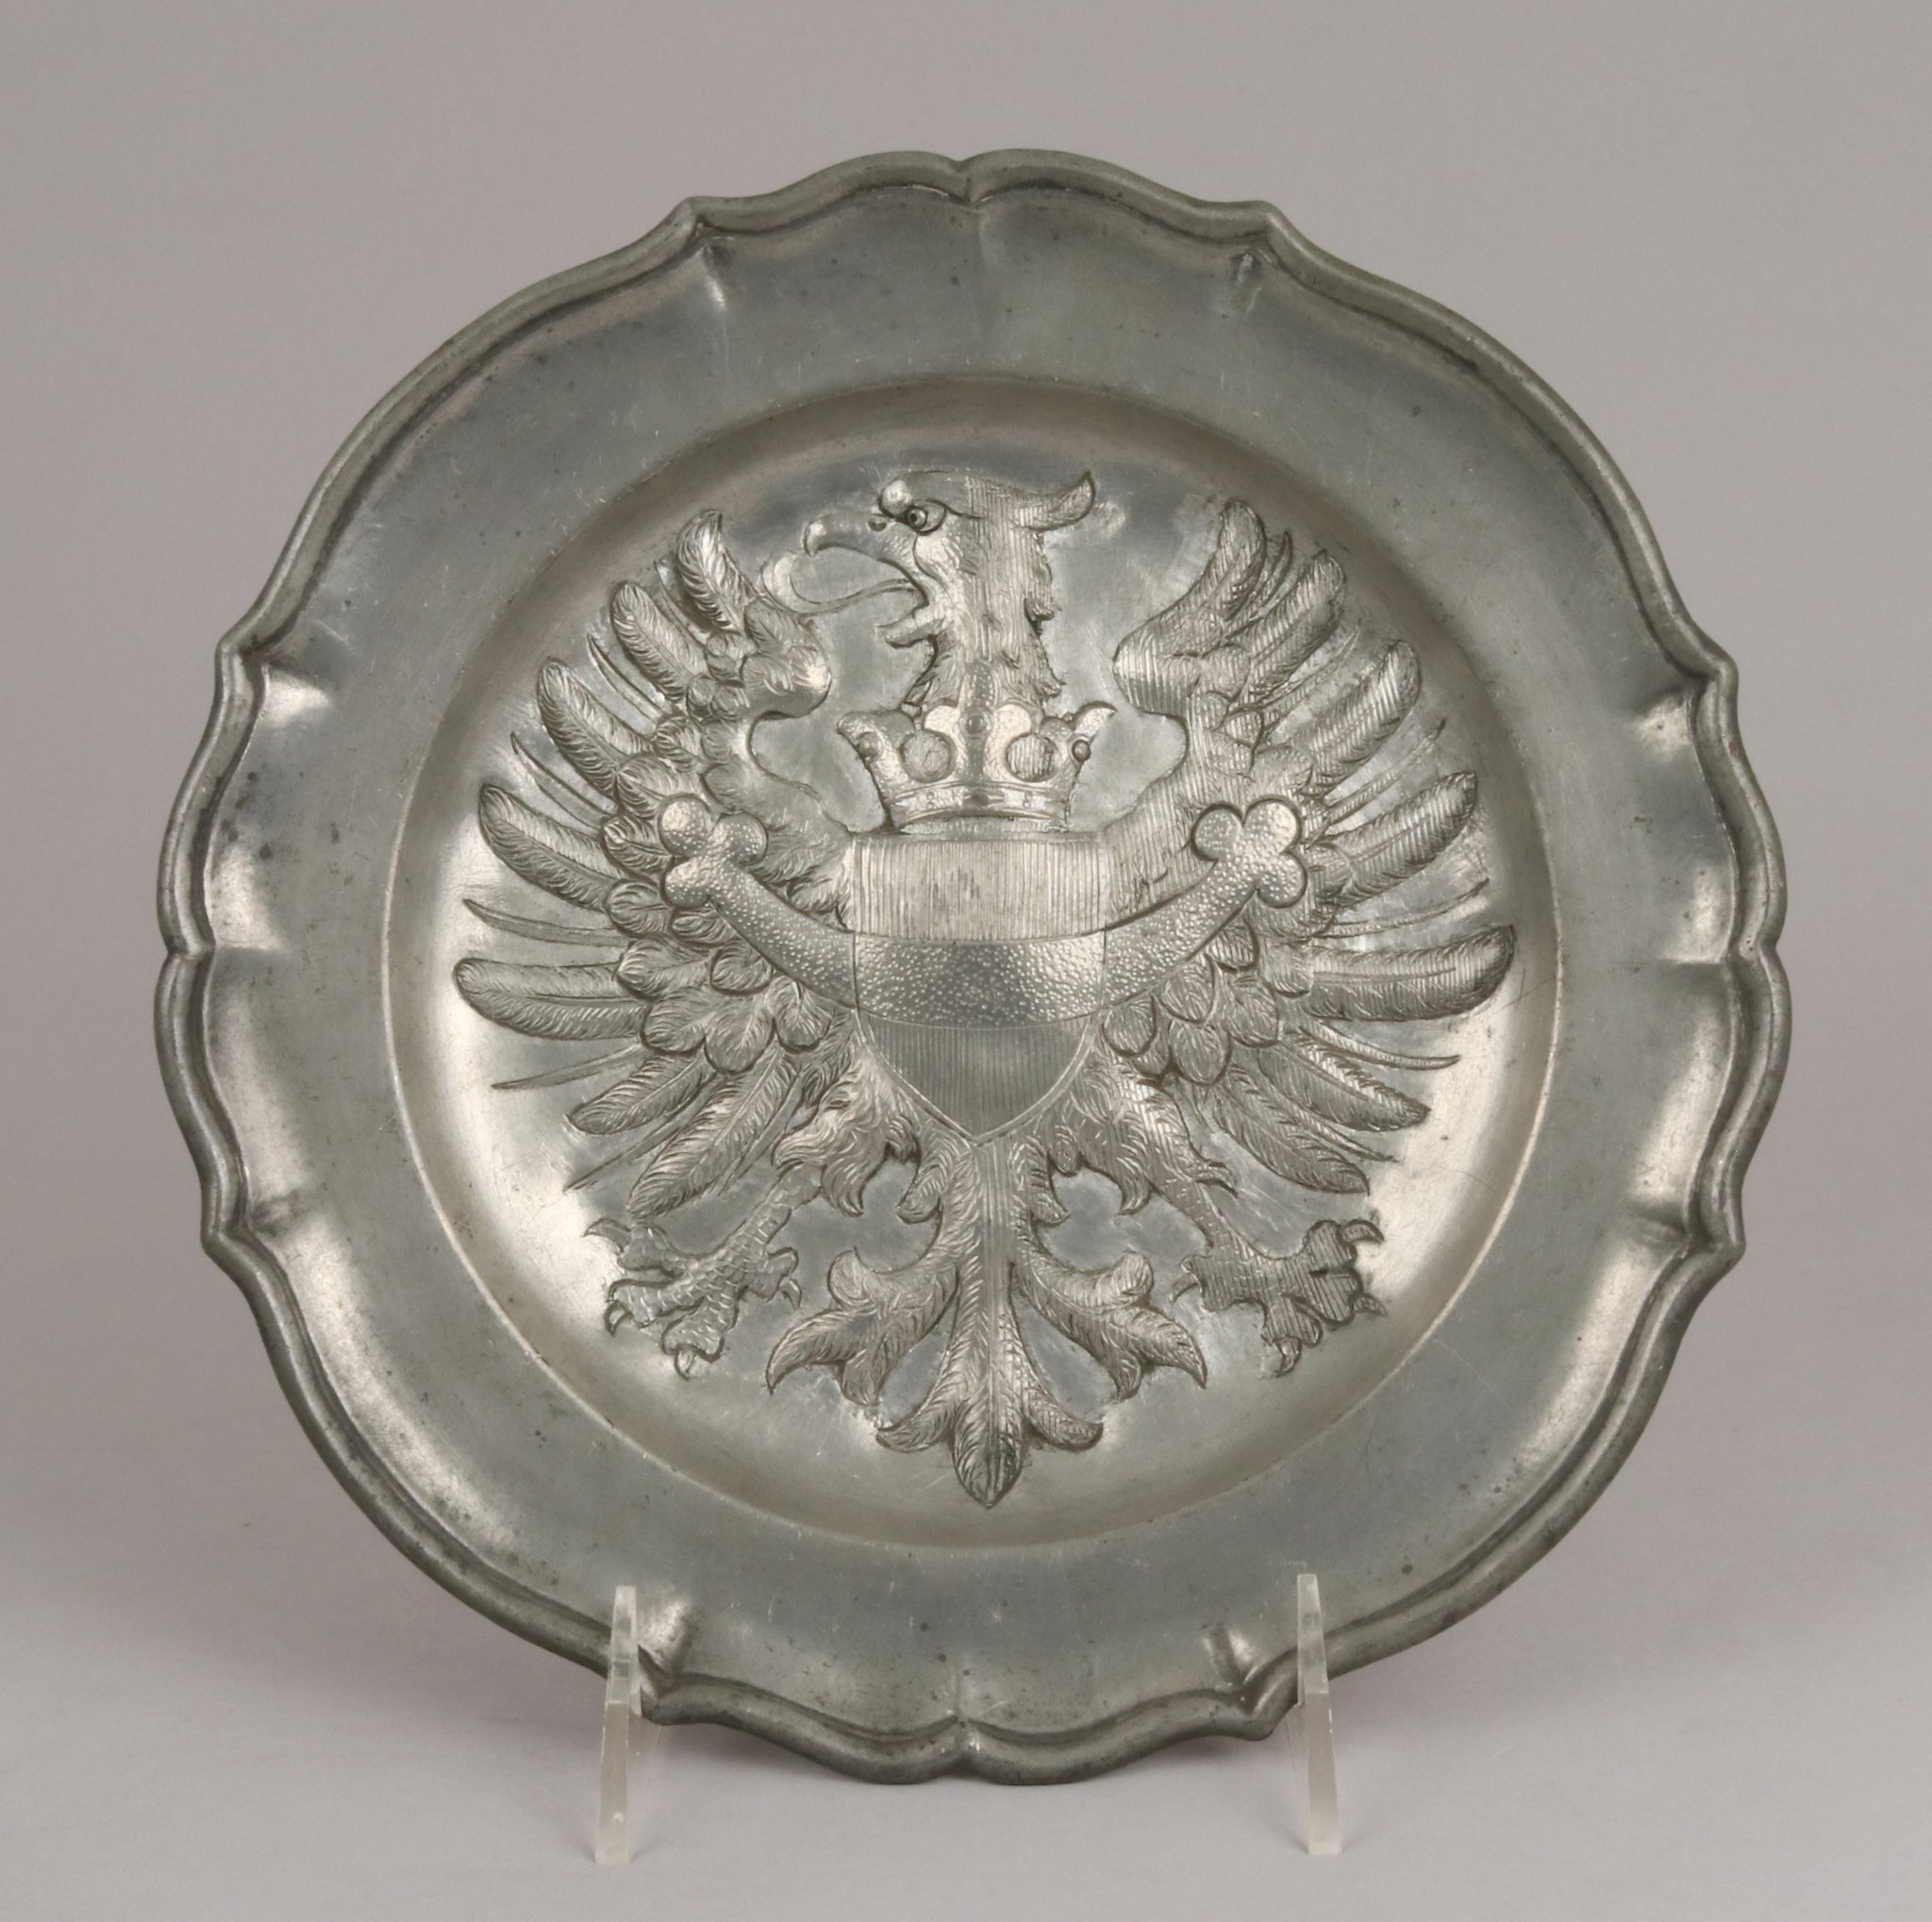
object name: plate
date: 1701-1800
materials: pewter